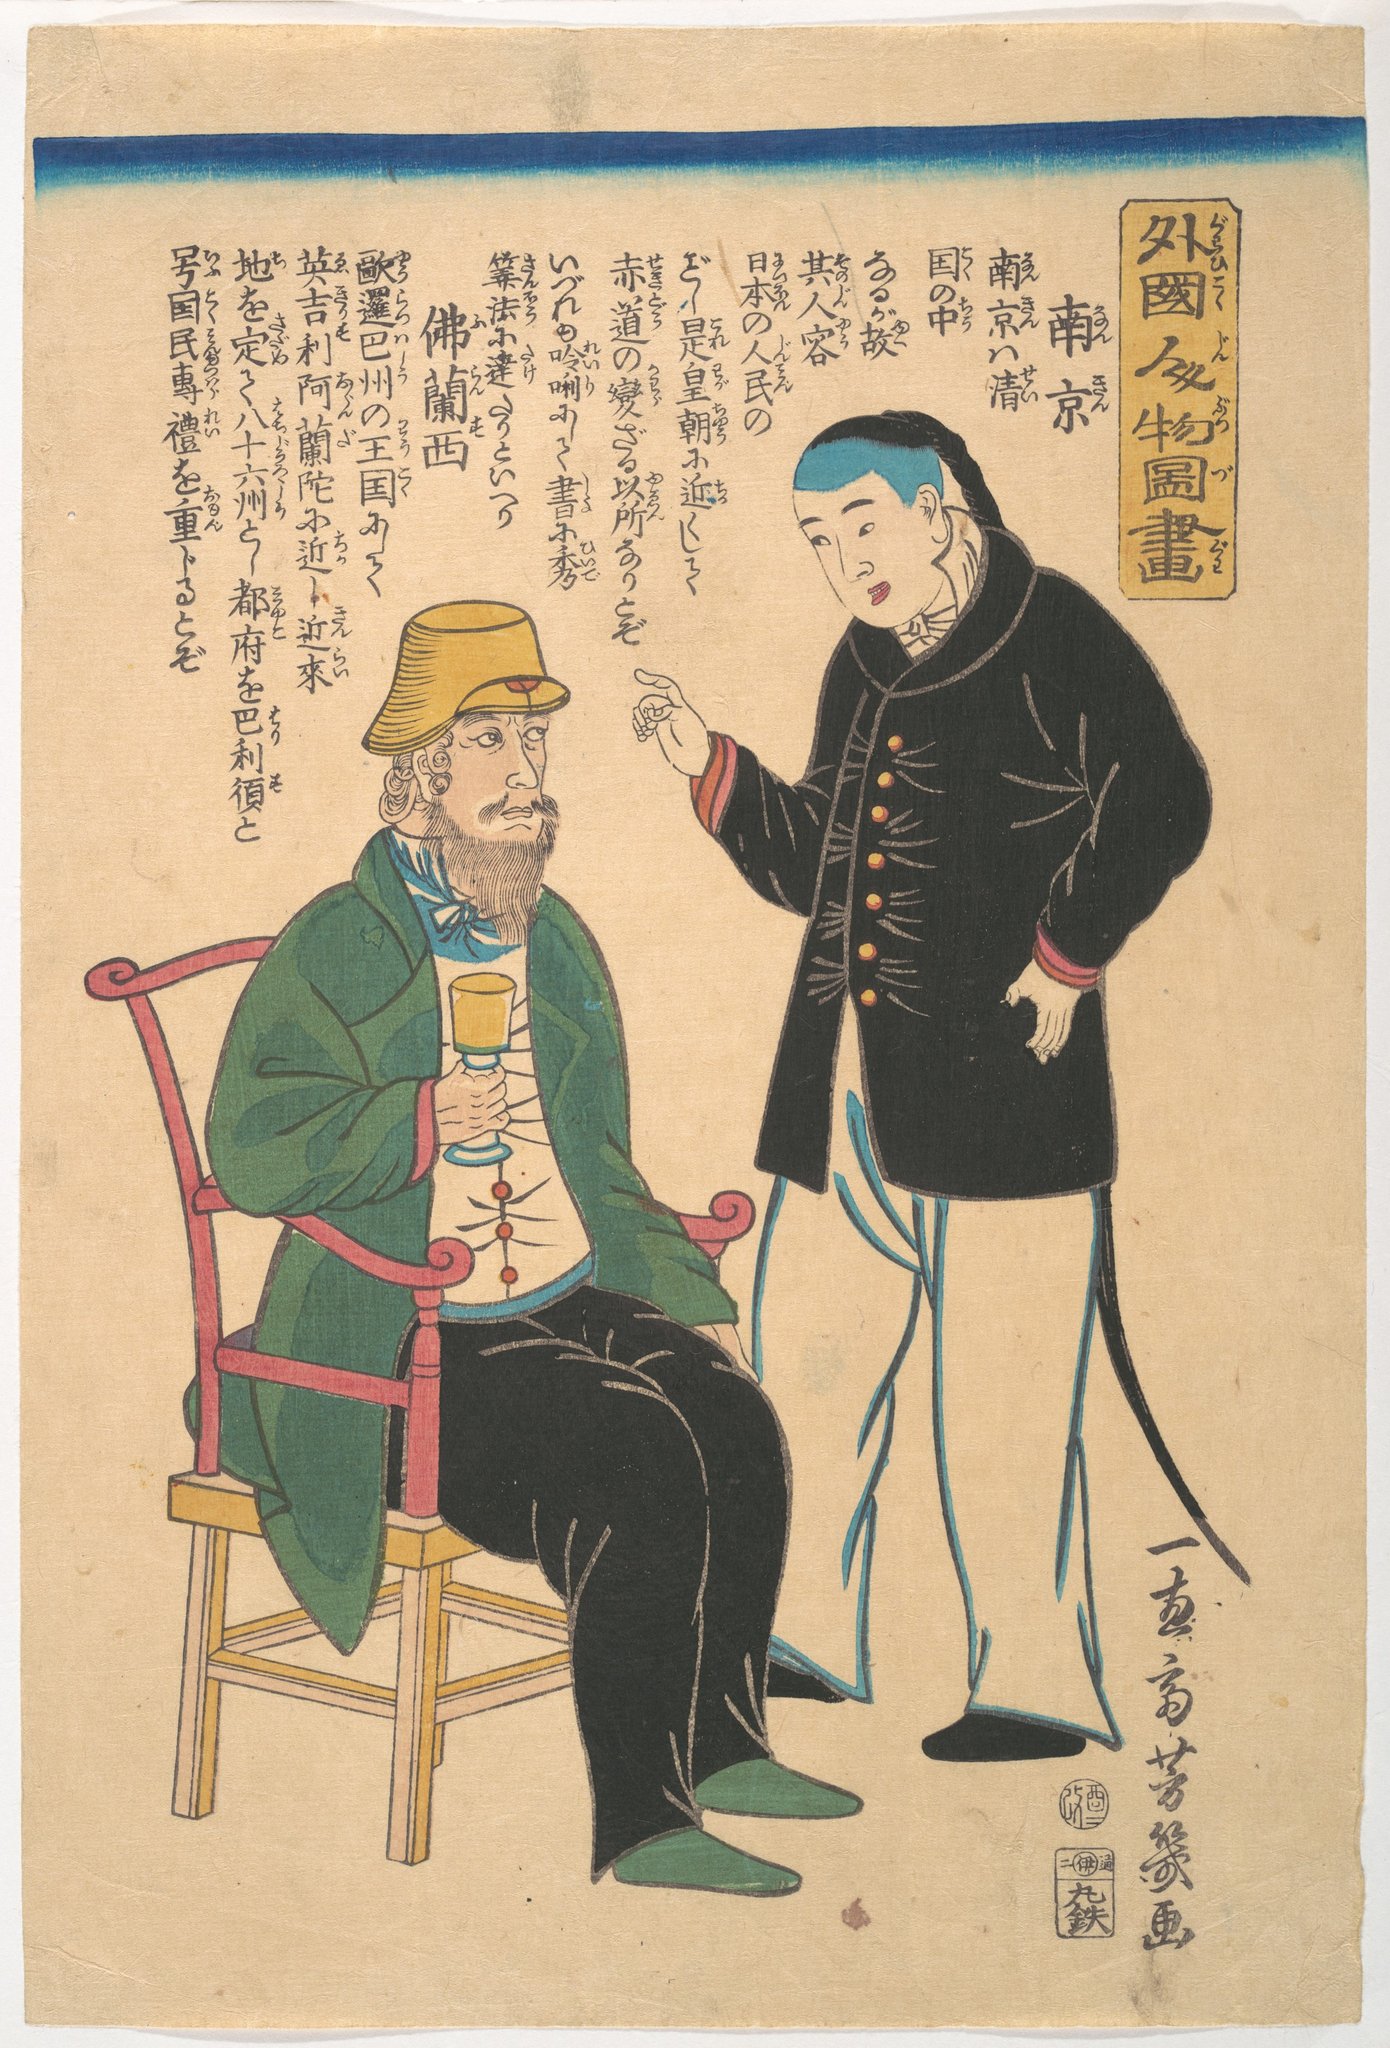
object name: print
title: Chinese Servant and Frenchman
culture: japanese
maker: utagawa yoshiiku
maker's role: artist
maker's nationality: japanese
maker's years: 1833-1904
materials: ink, paper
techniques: woodblock print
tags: men,servants